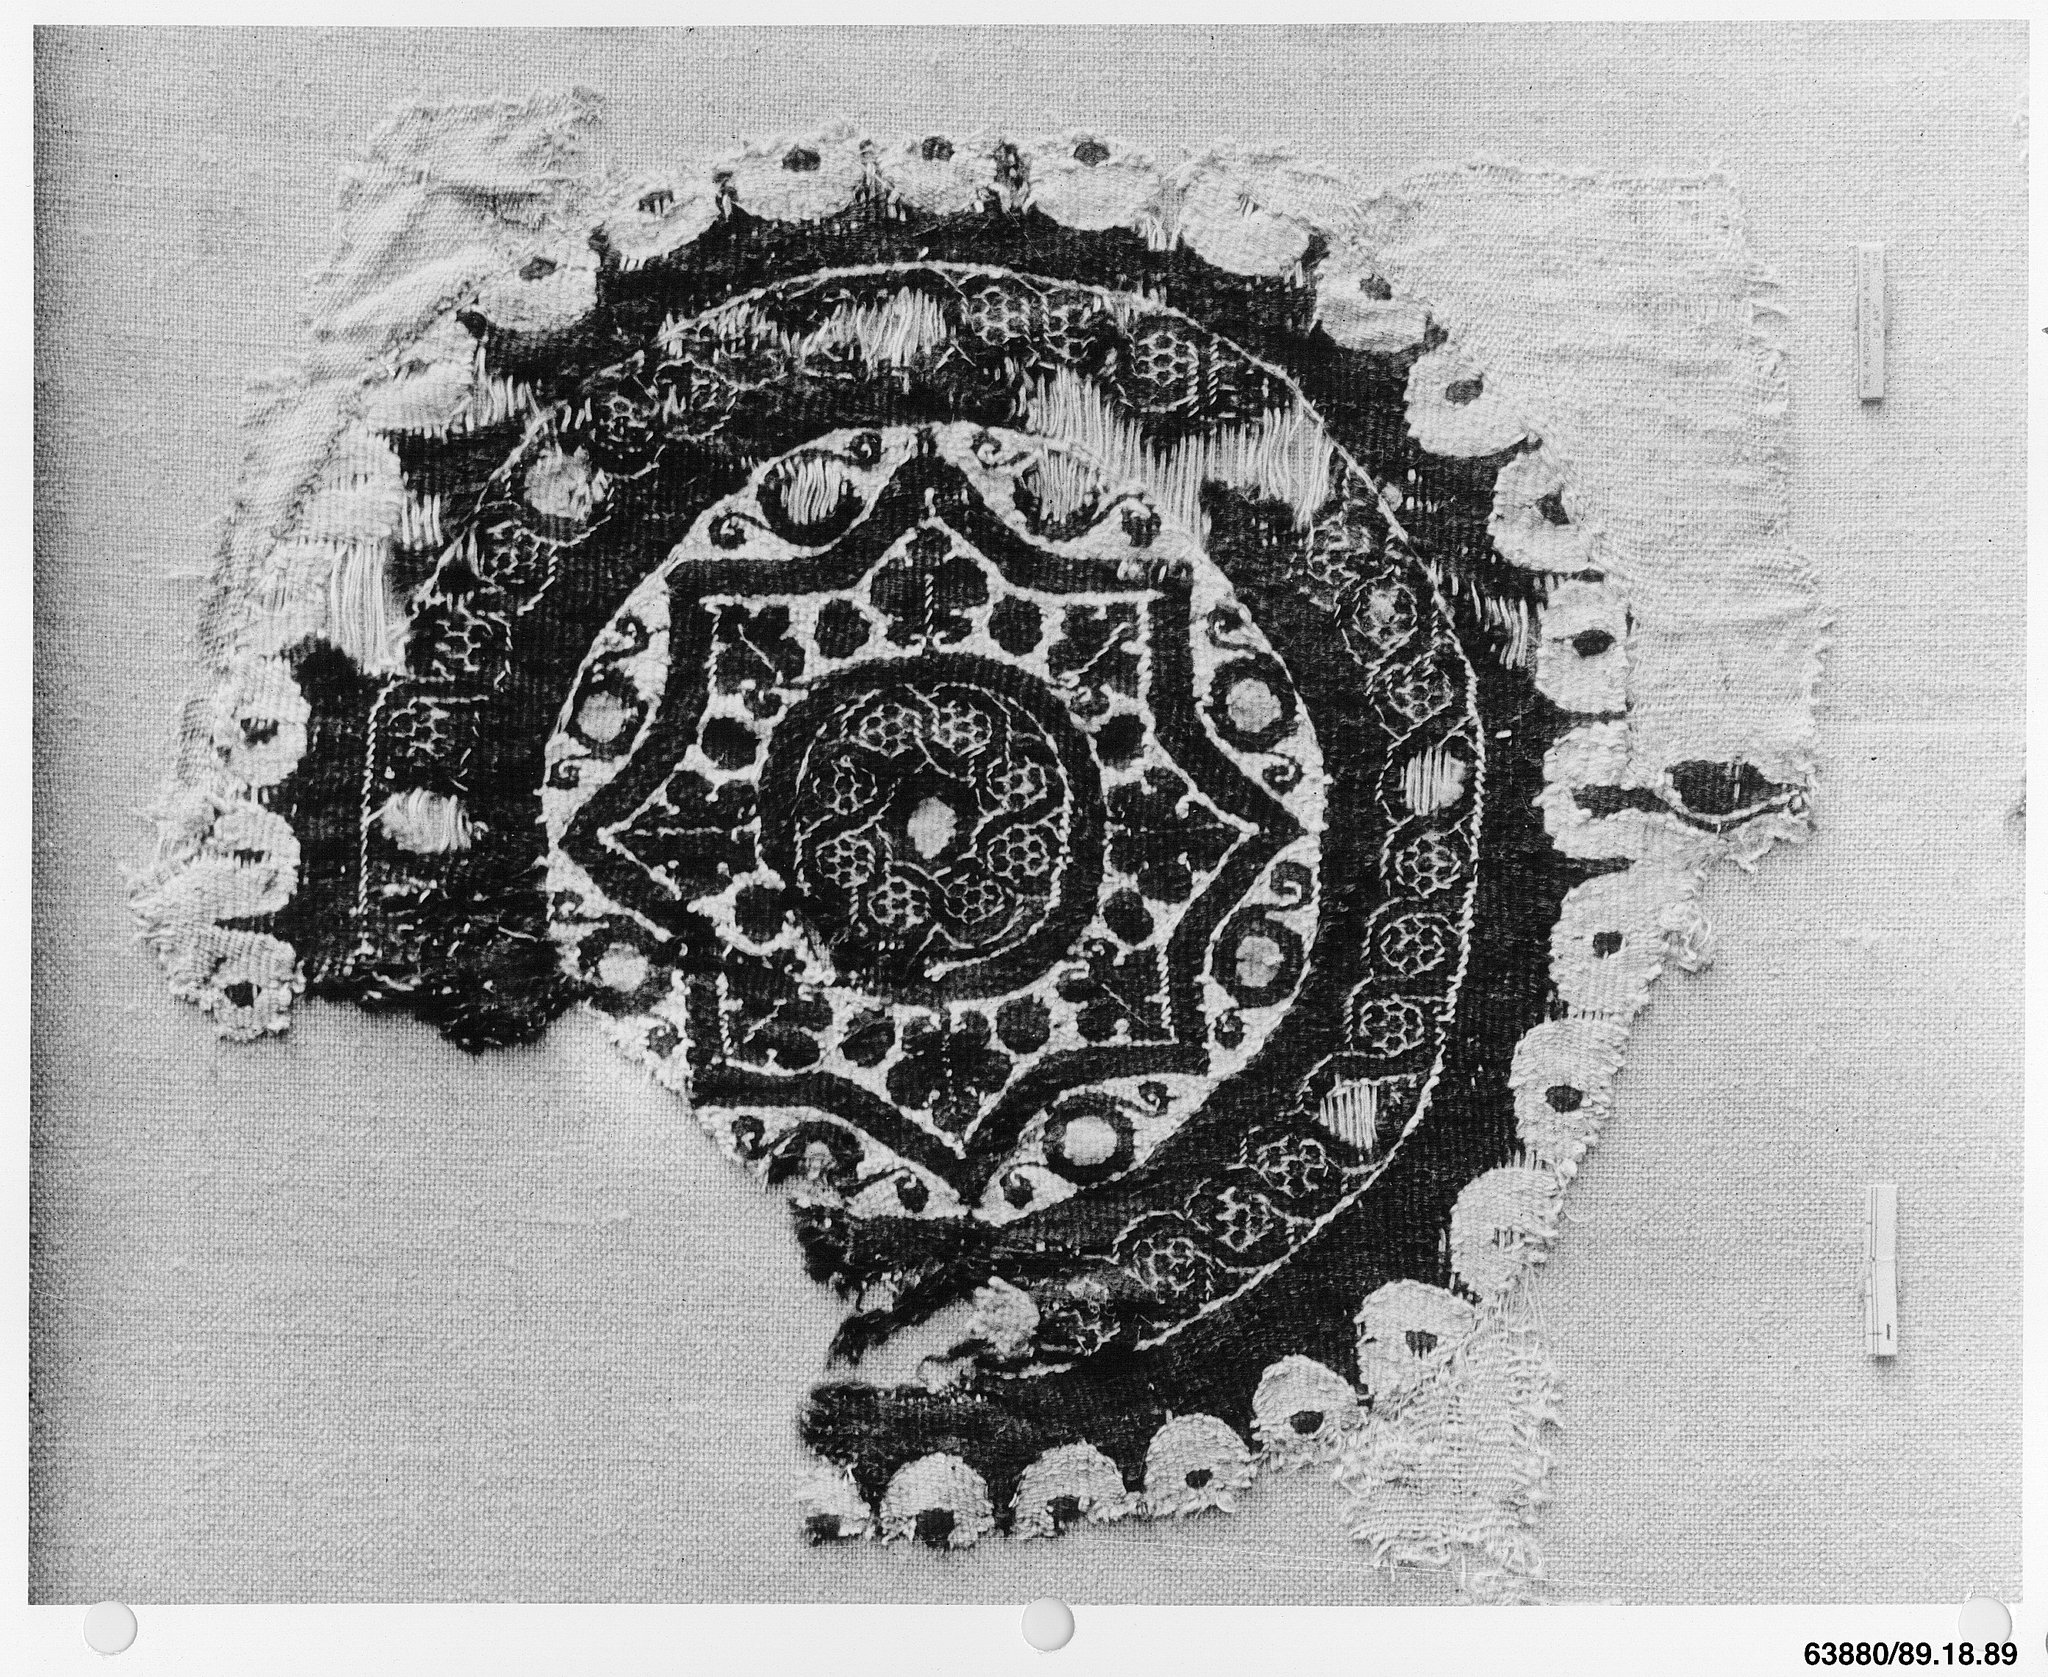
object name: textile fragment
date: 201-400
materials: linen, wool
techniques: weave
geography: egypt